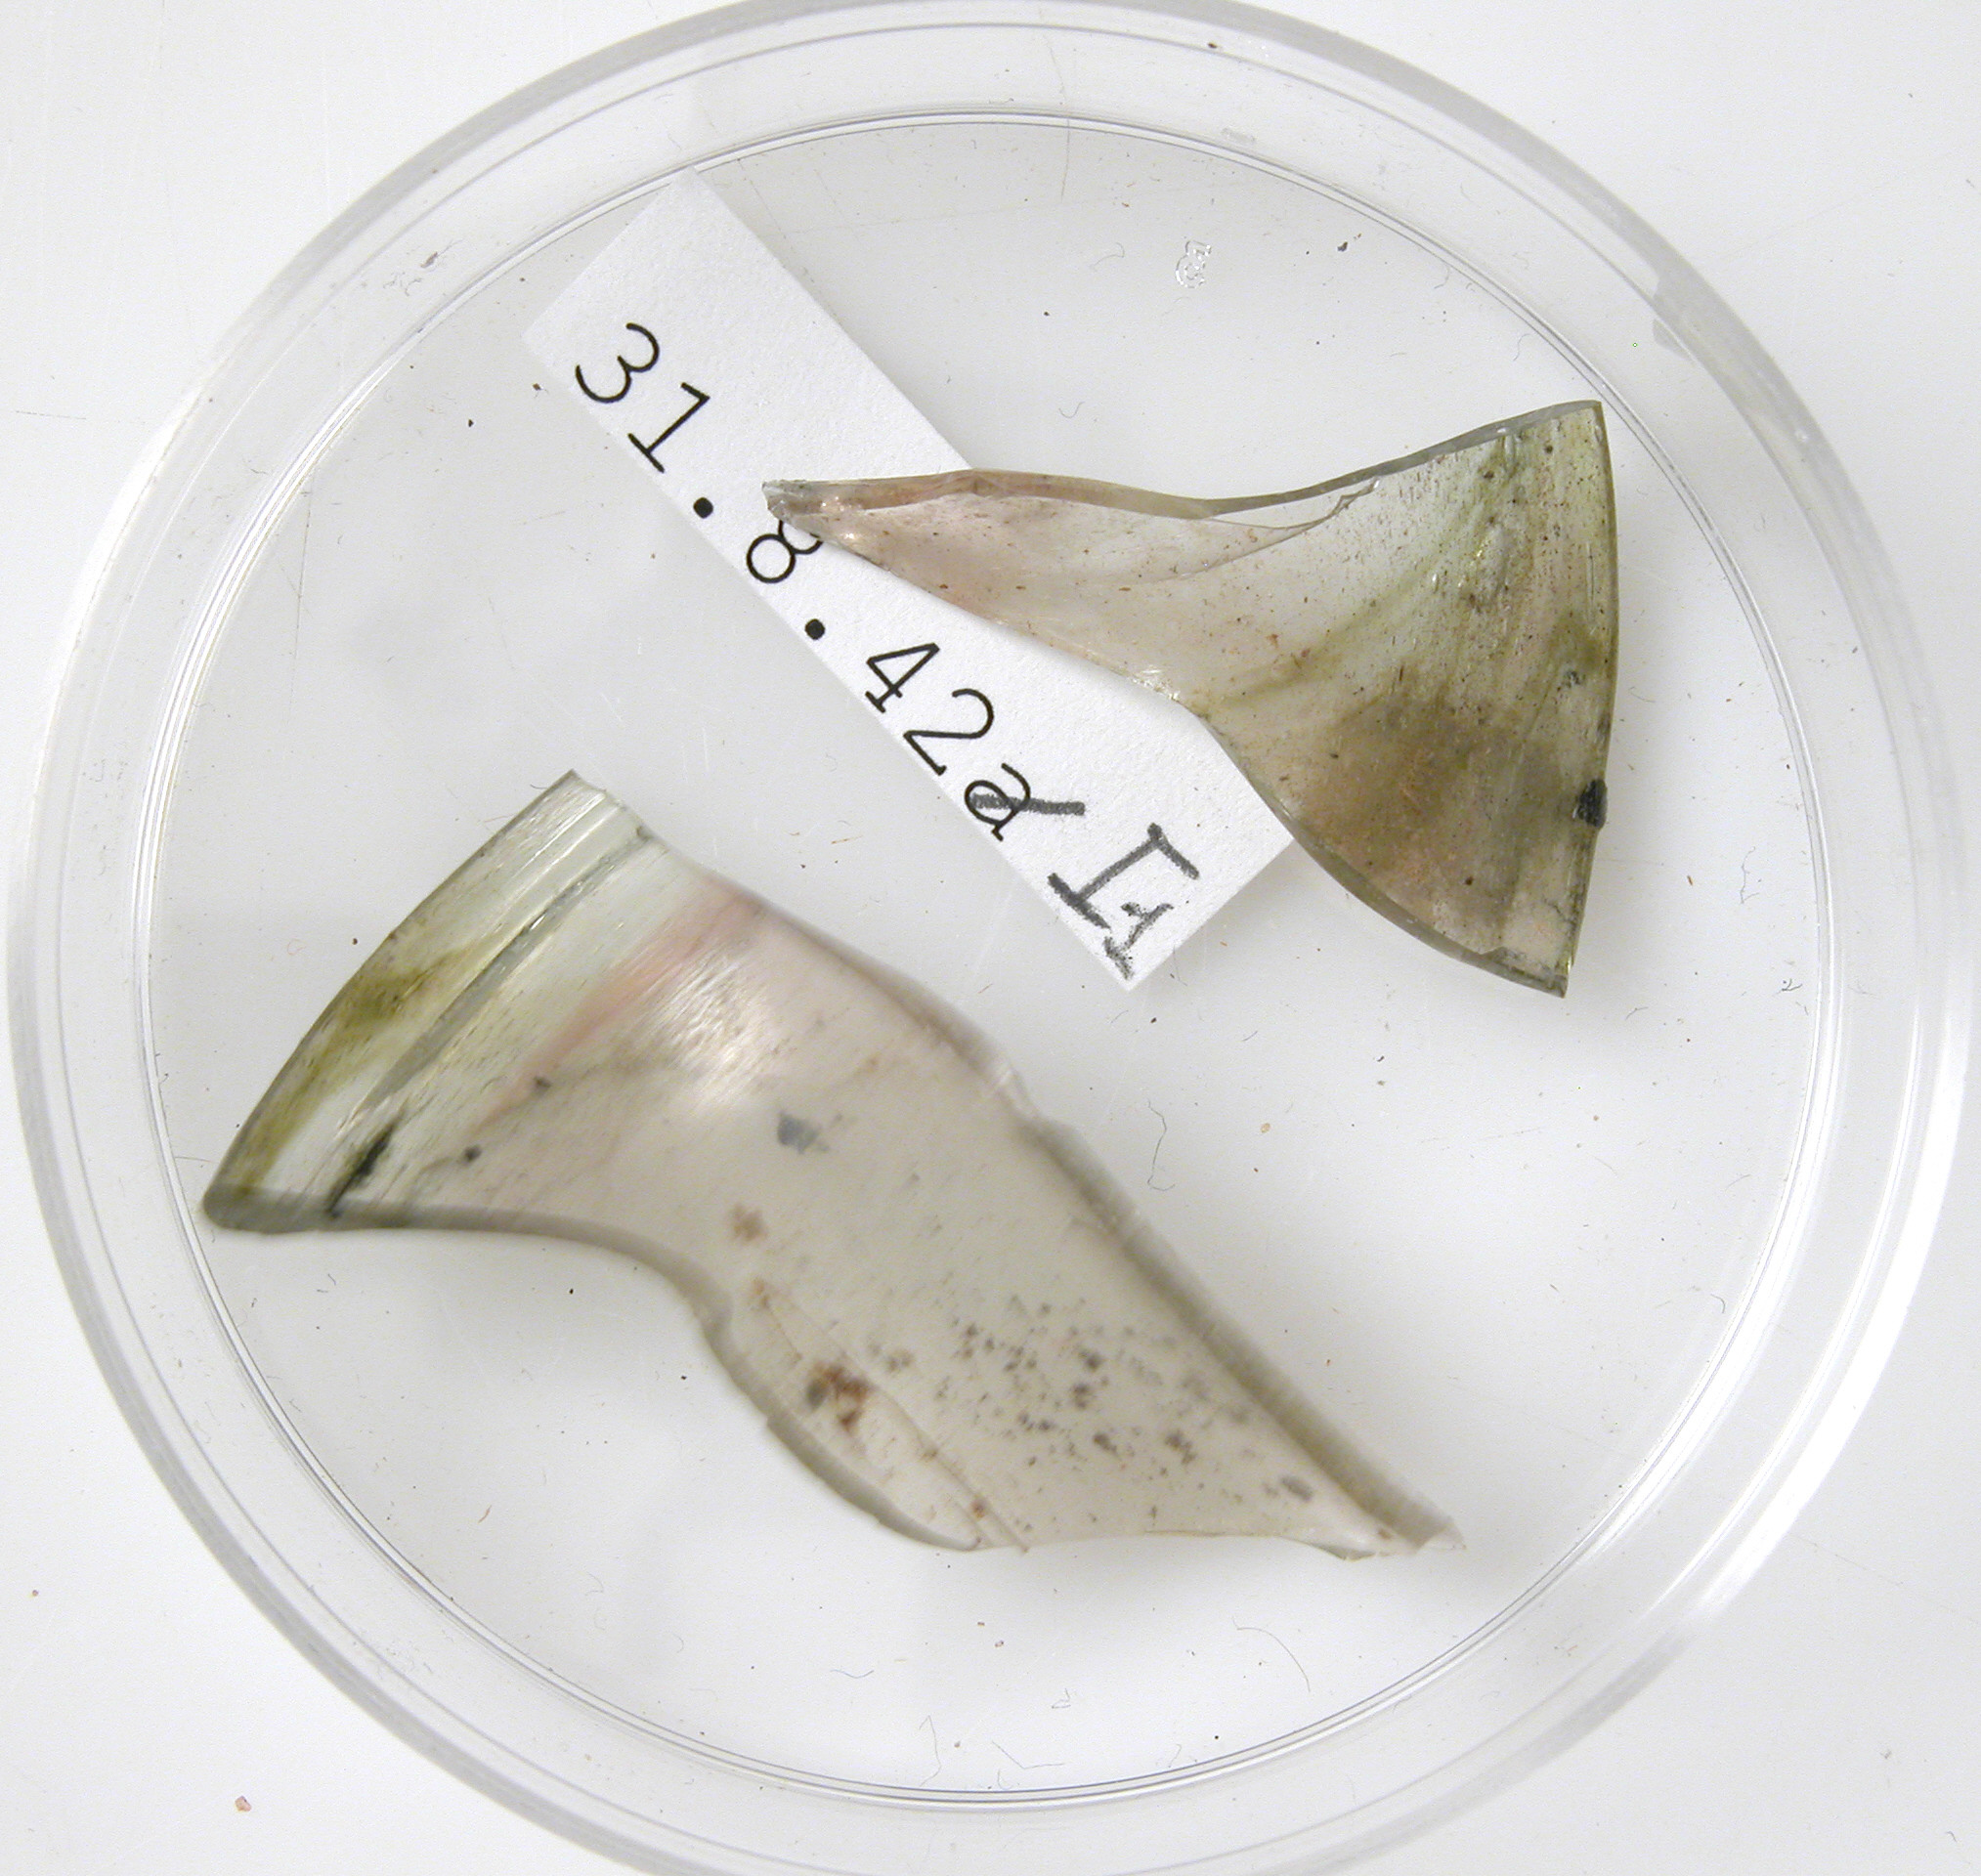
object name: fragment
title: Glass Fragments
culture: coptic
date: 301-400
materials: glass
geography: egypt